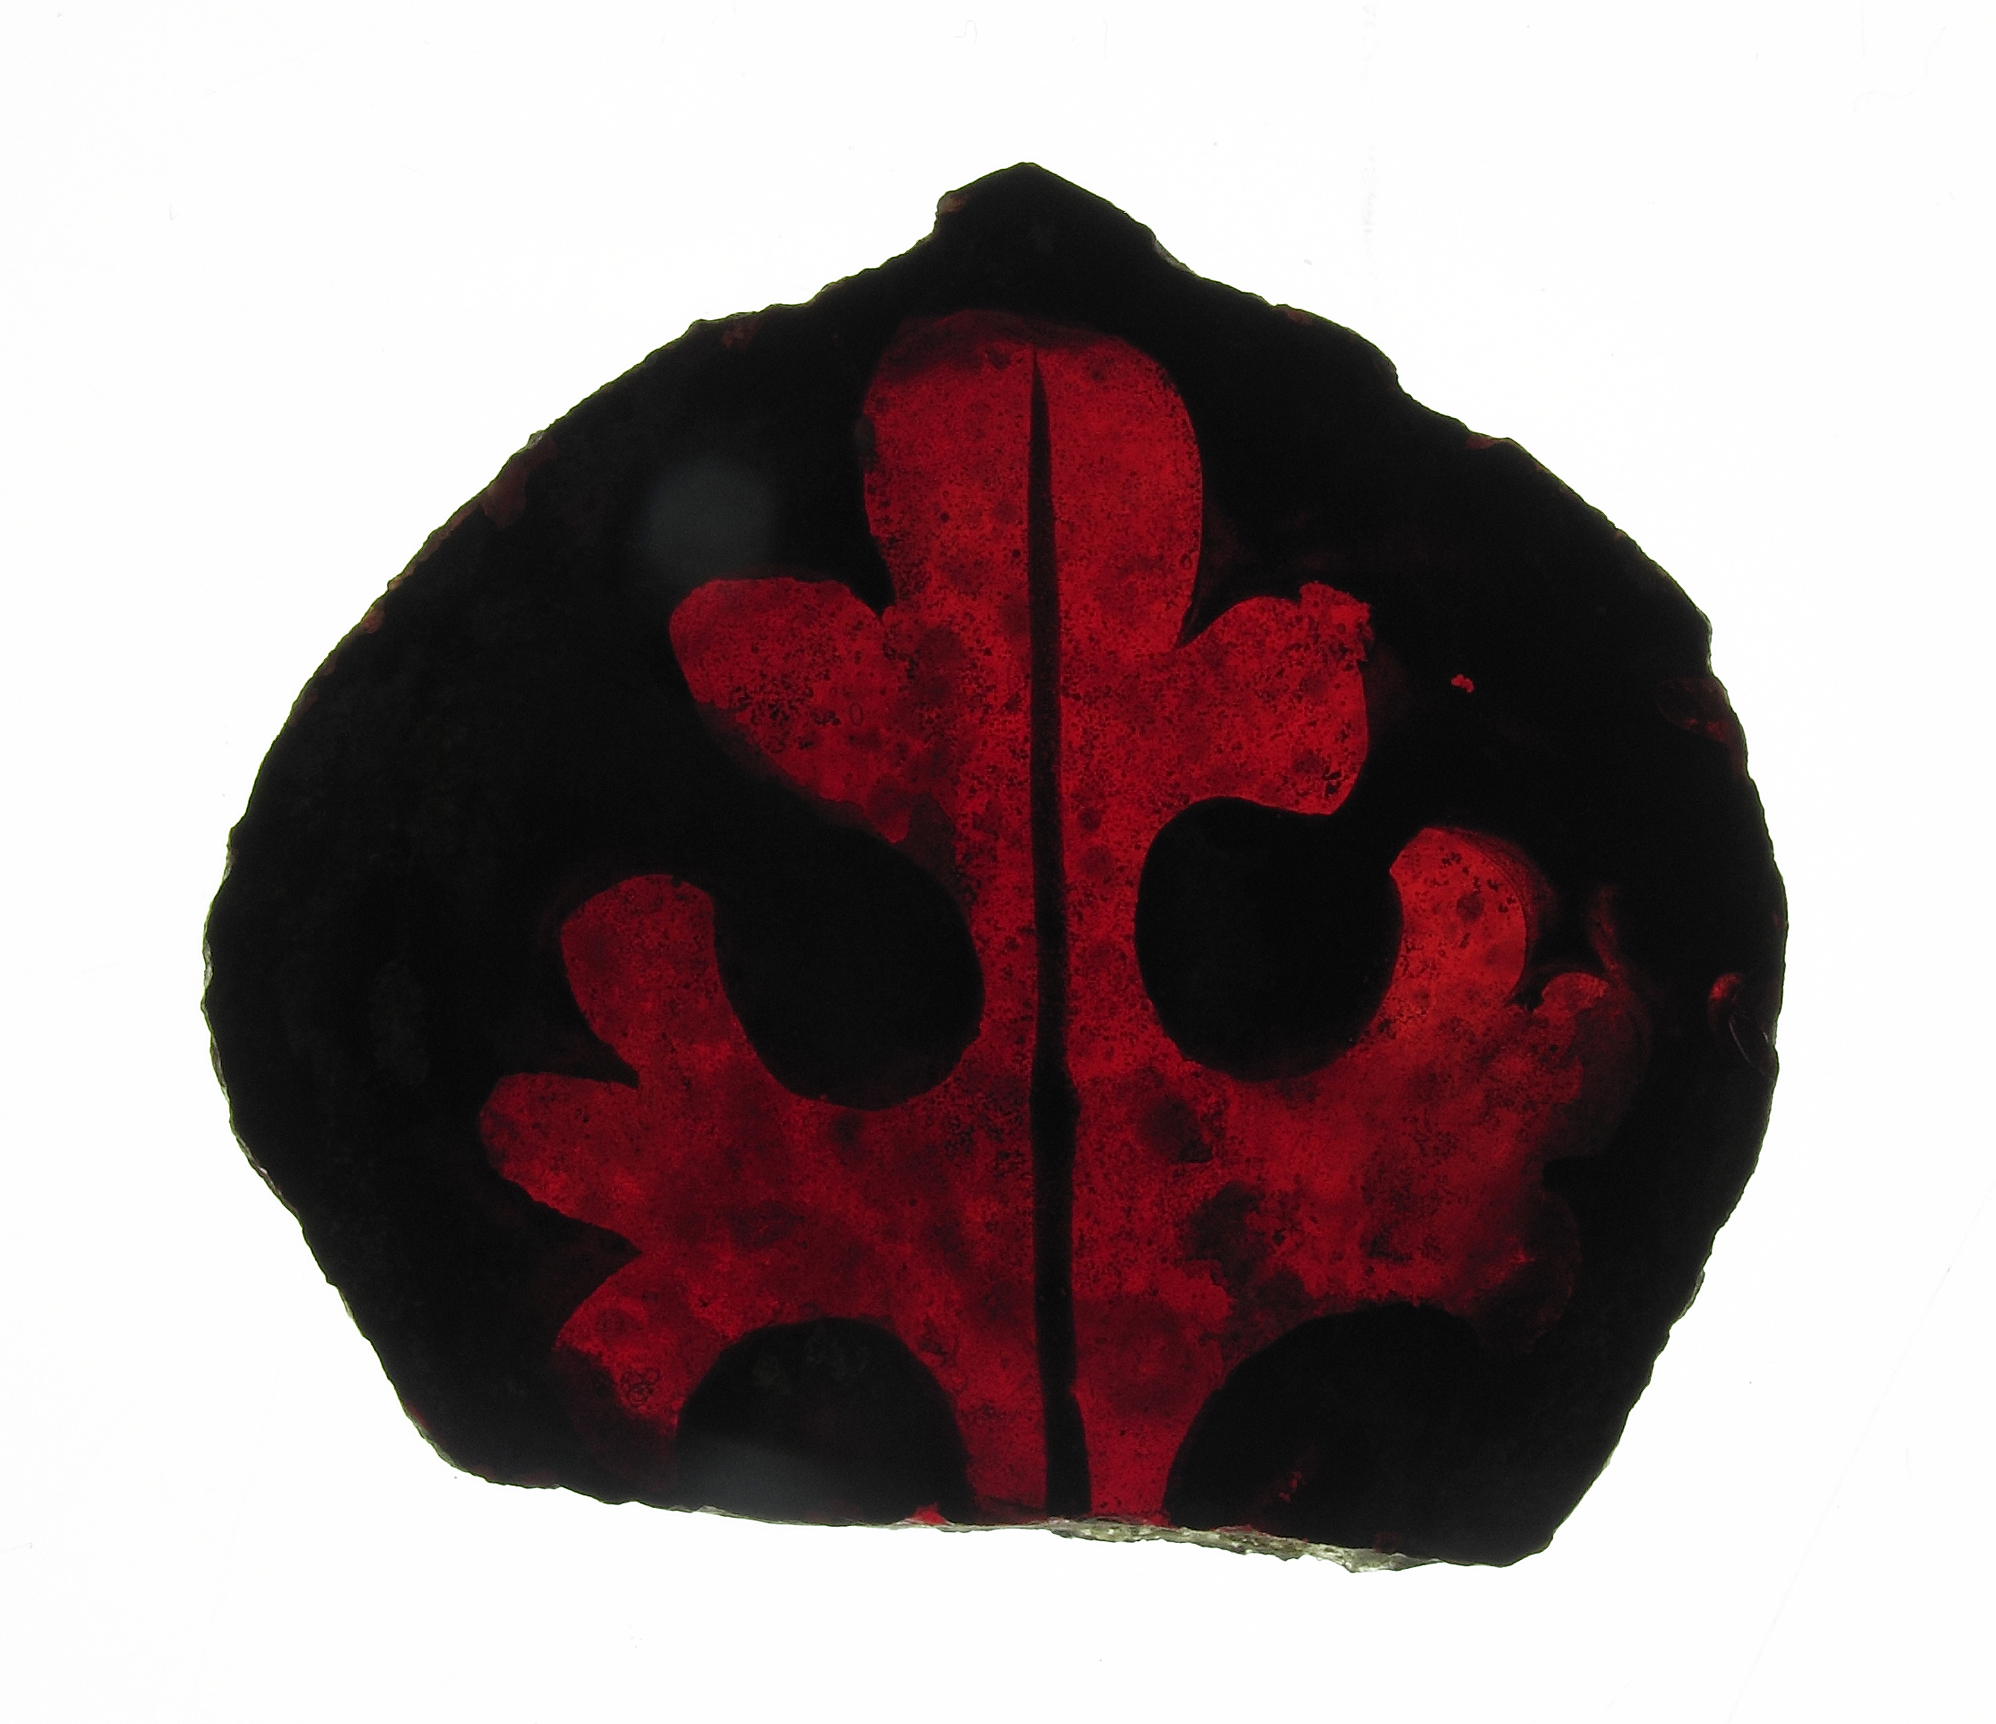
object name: fragment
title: Glass Fragment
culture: european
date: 1201-1300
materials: glass, metal